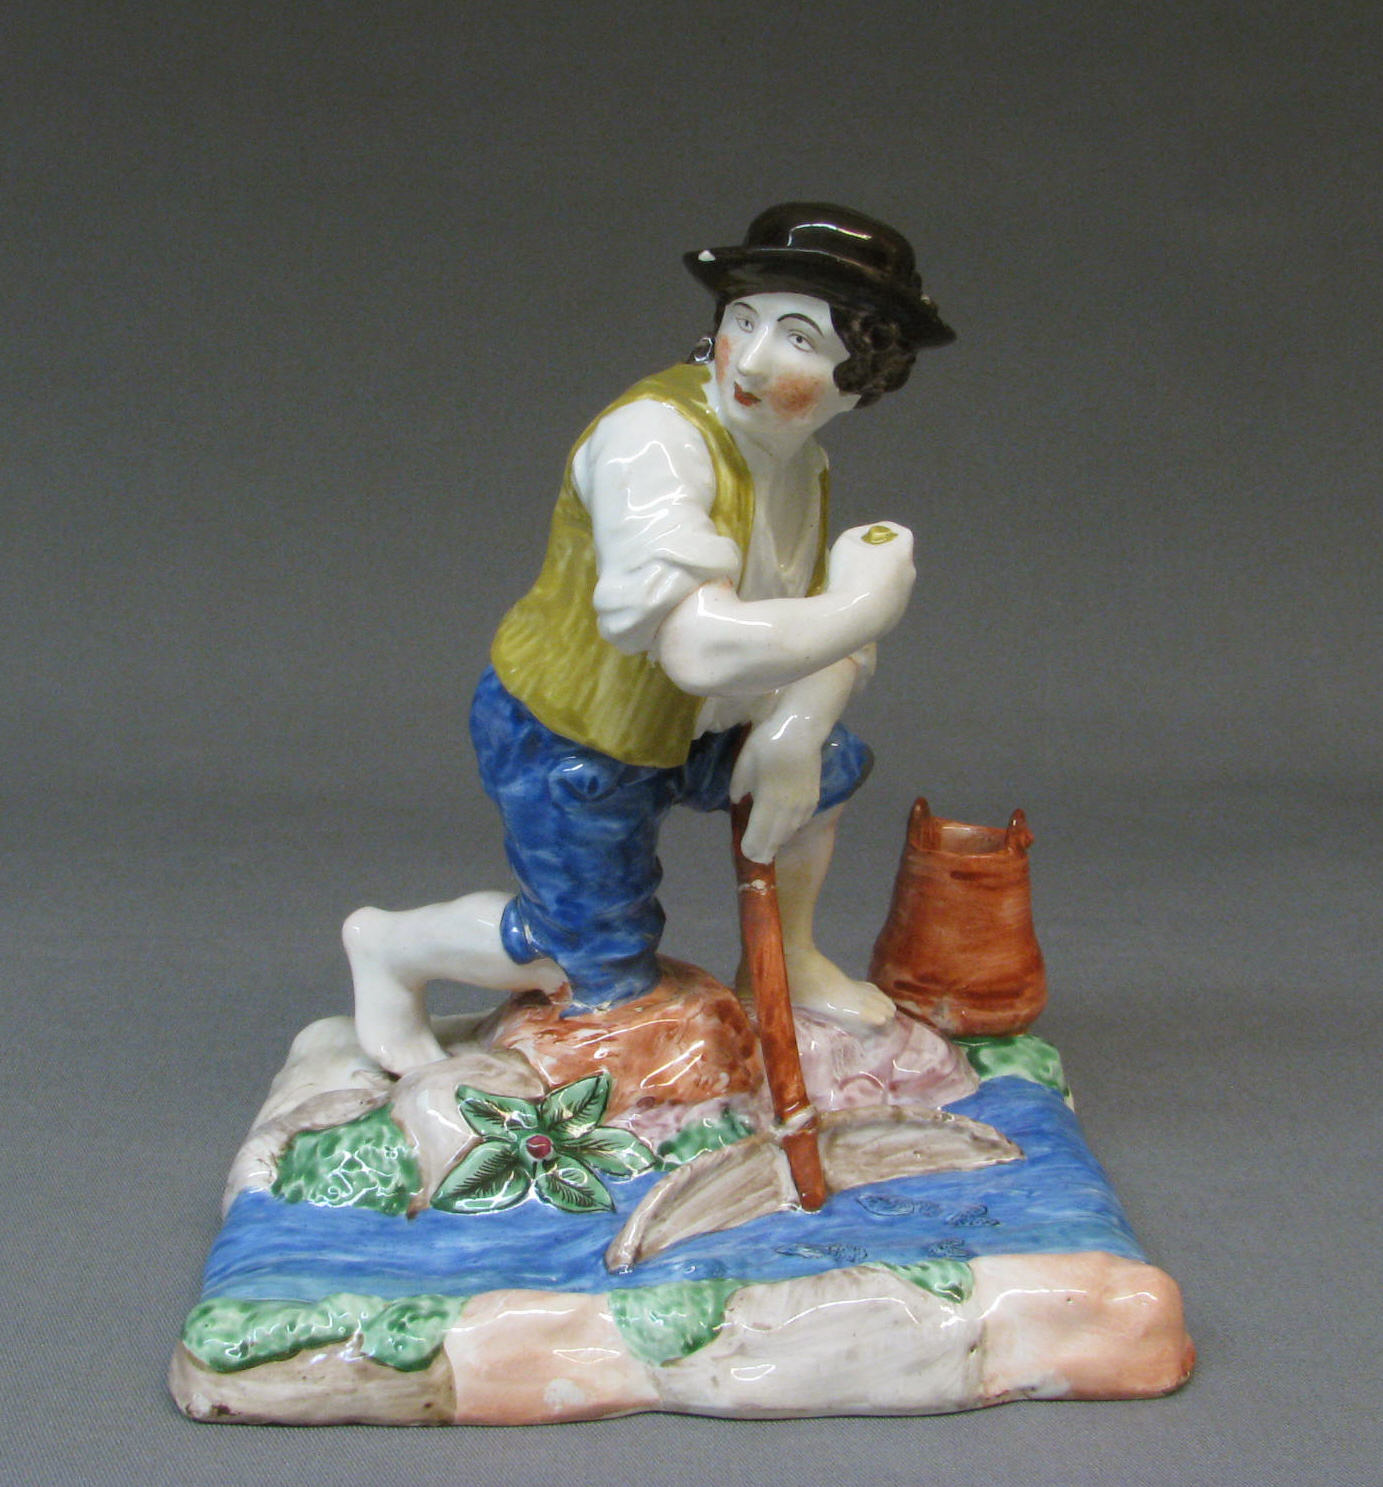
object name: inkstand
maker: paul-louis cyfflé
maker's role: modeler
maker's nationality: french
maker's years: 1724-1806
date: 1760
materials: faience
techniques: glazing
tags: men